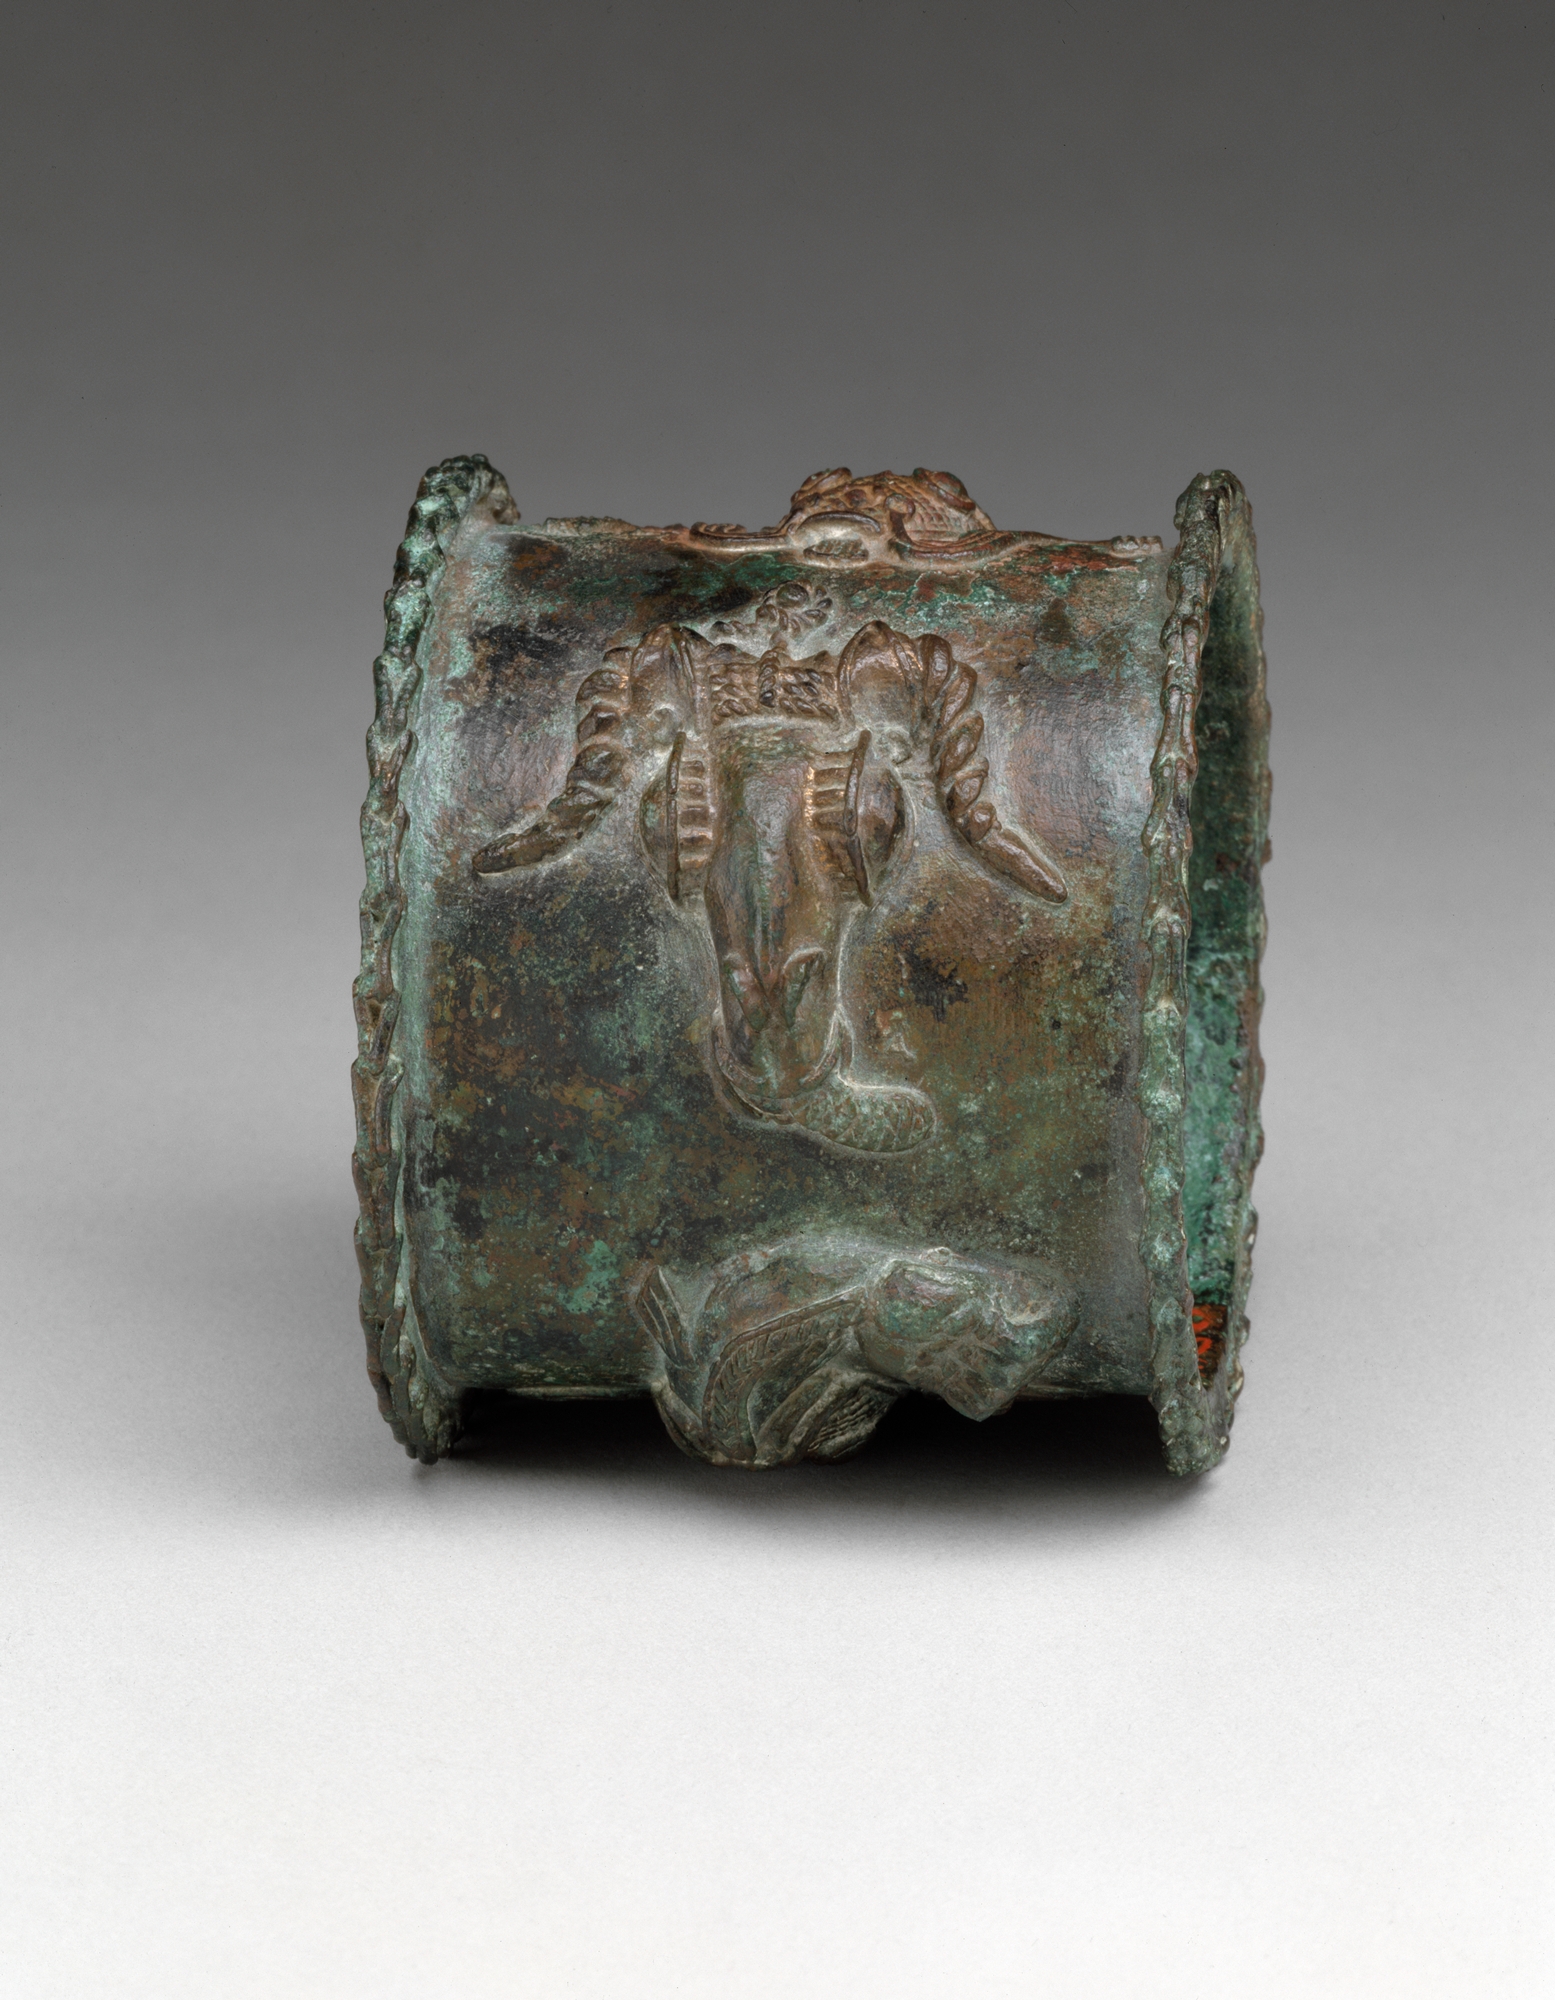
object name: bracelet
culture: yoruba peoples, ijebu group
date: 1701-1800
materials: brass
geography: nigeria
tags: animals